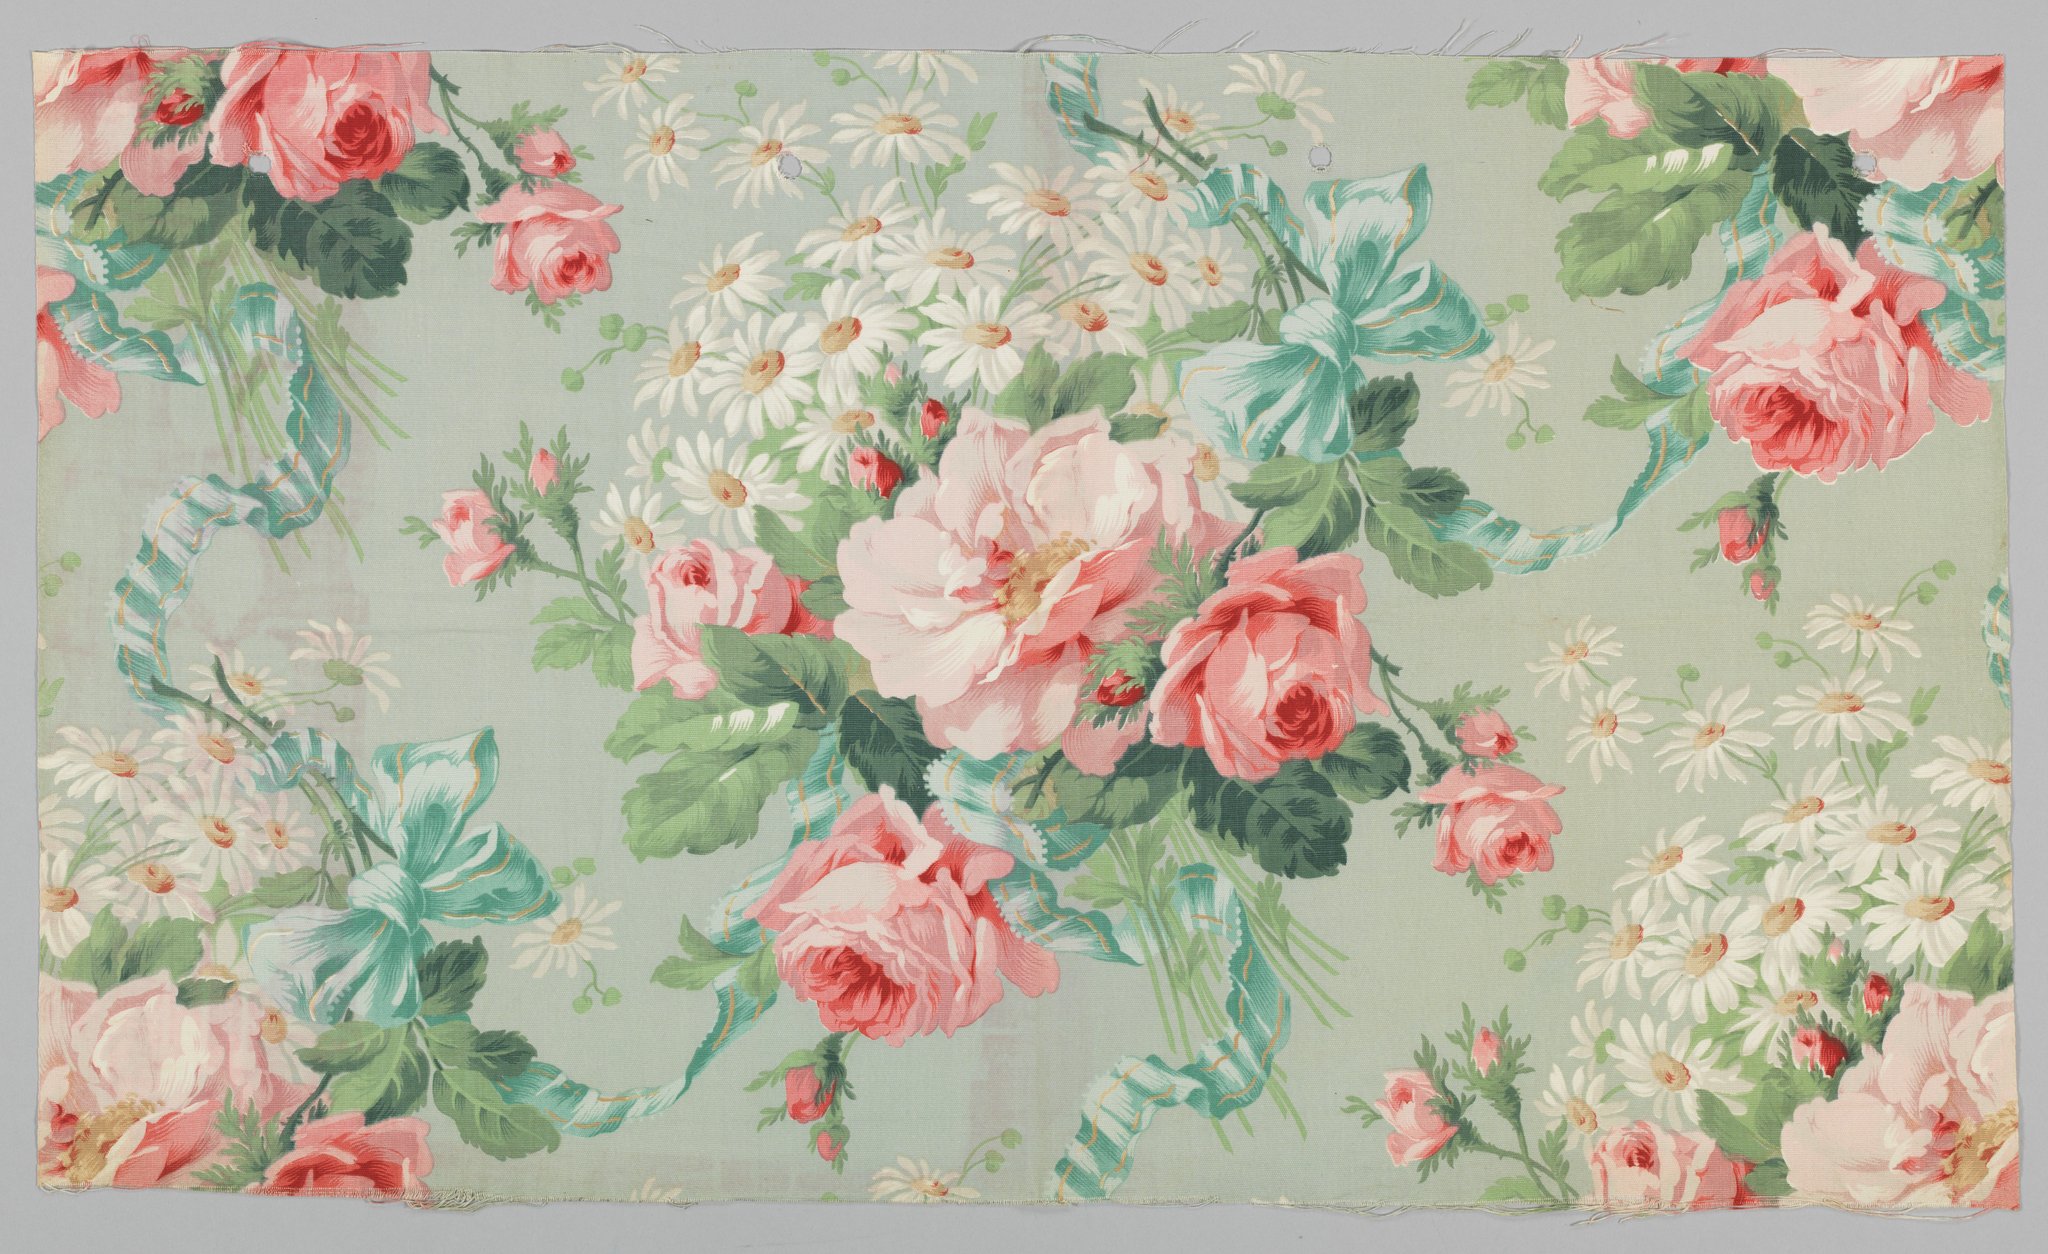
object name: piece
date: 1890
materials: cotton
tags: flowers